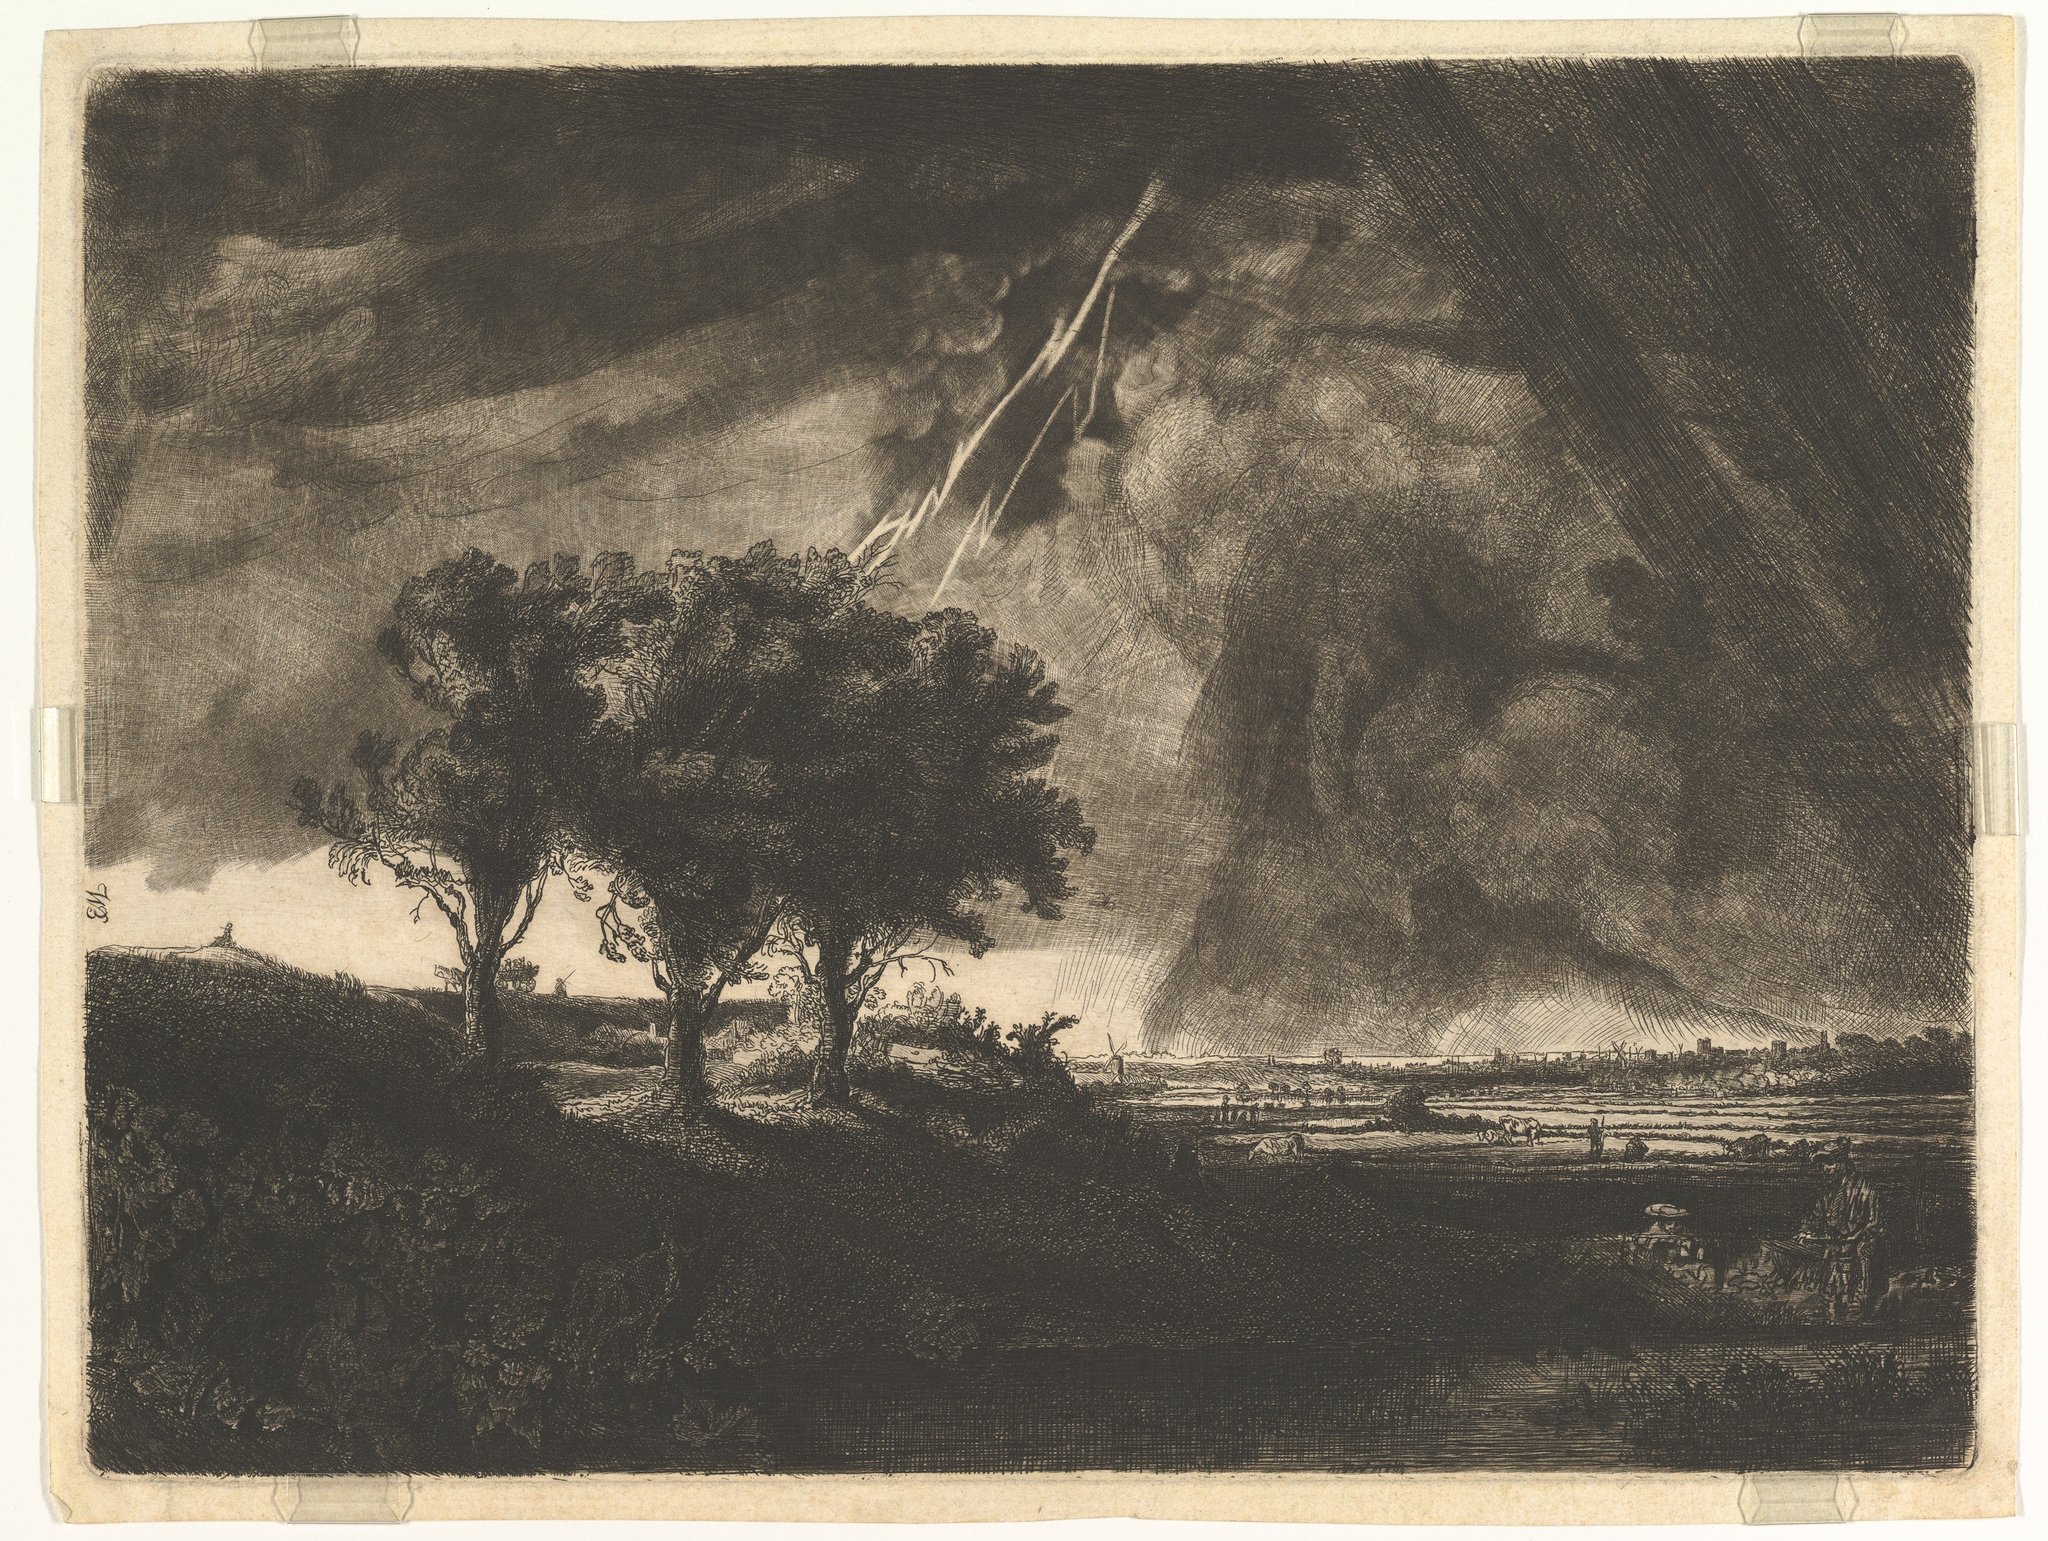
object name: print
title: The Three Trees, after Rembrandt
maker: william baillie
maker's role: artist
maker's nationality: irish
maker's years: 1723-1810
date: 1758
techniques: drypoint, etching, roulette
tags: landscapes,trees,lightning